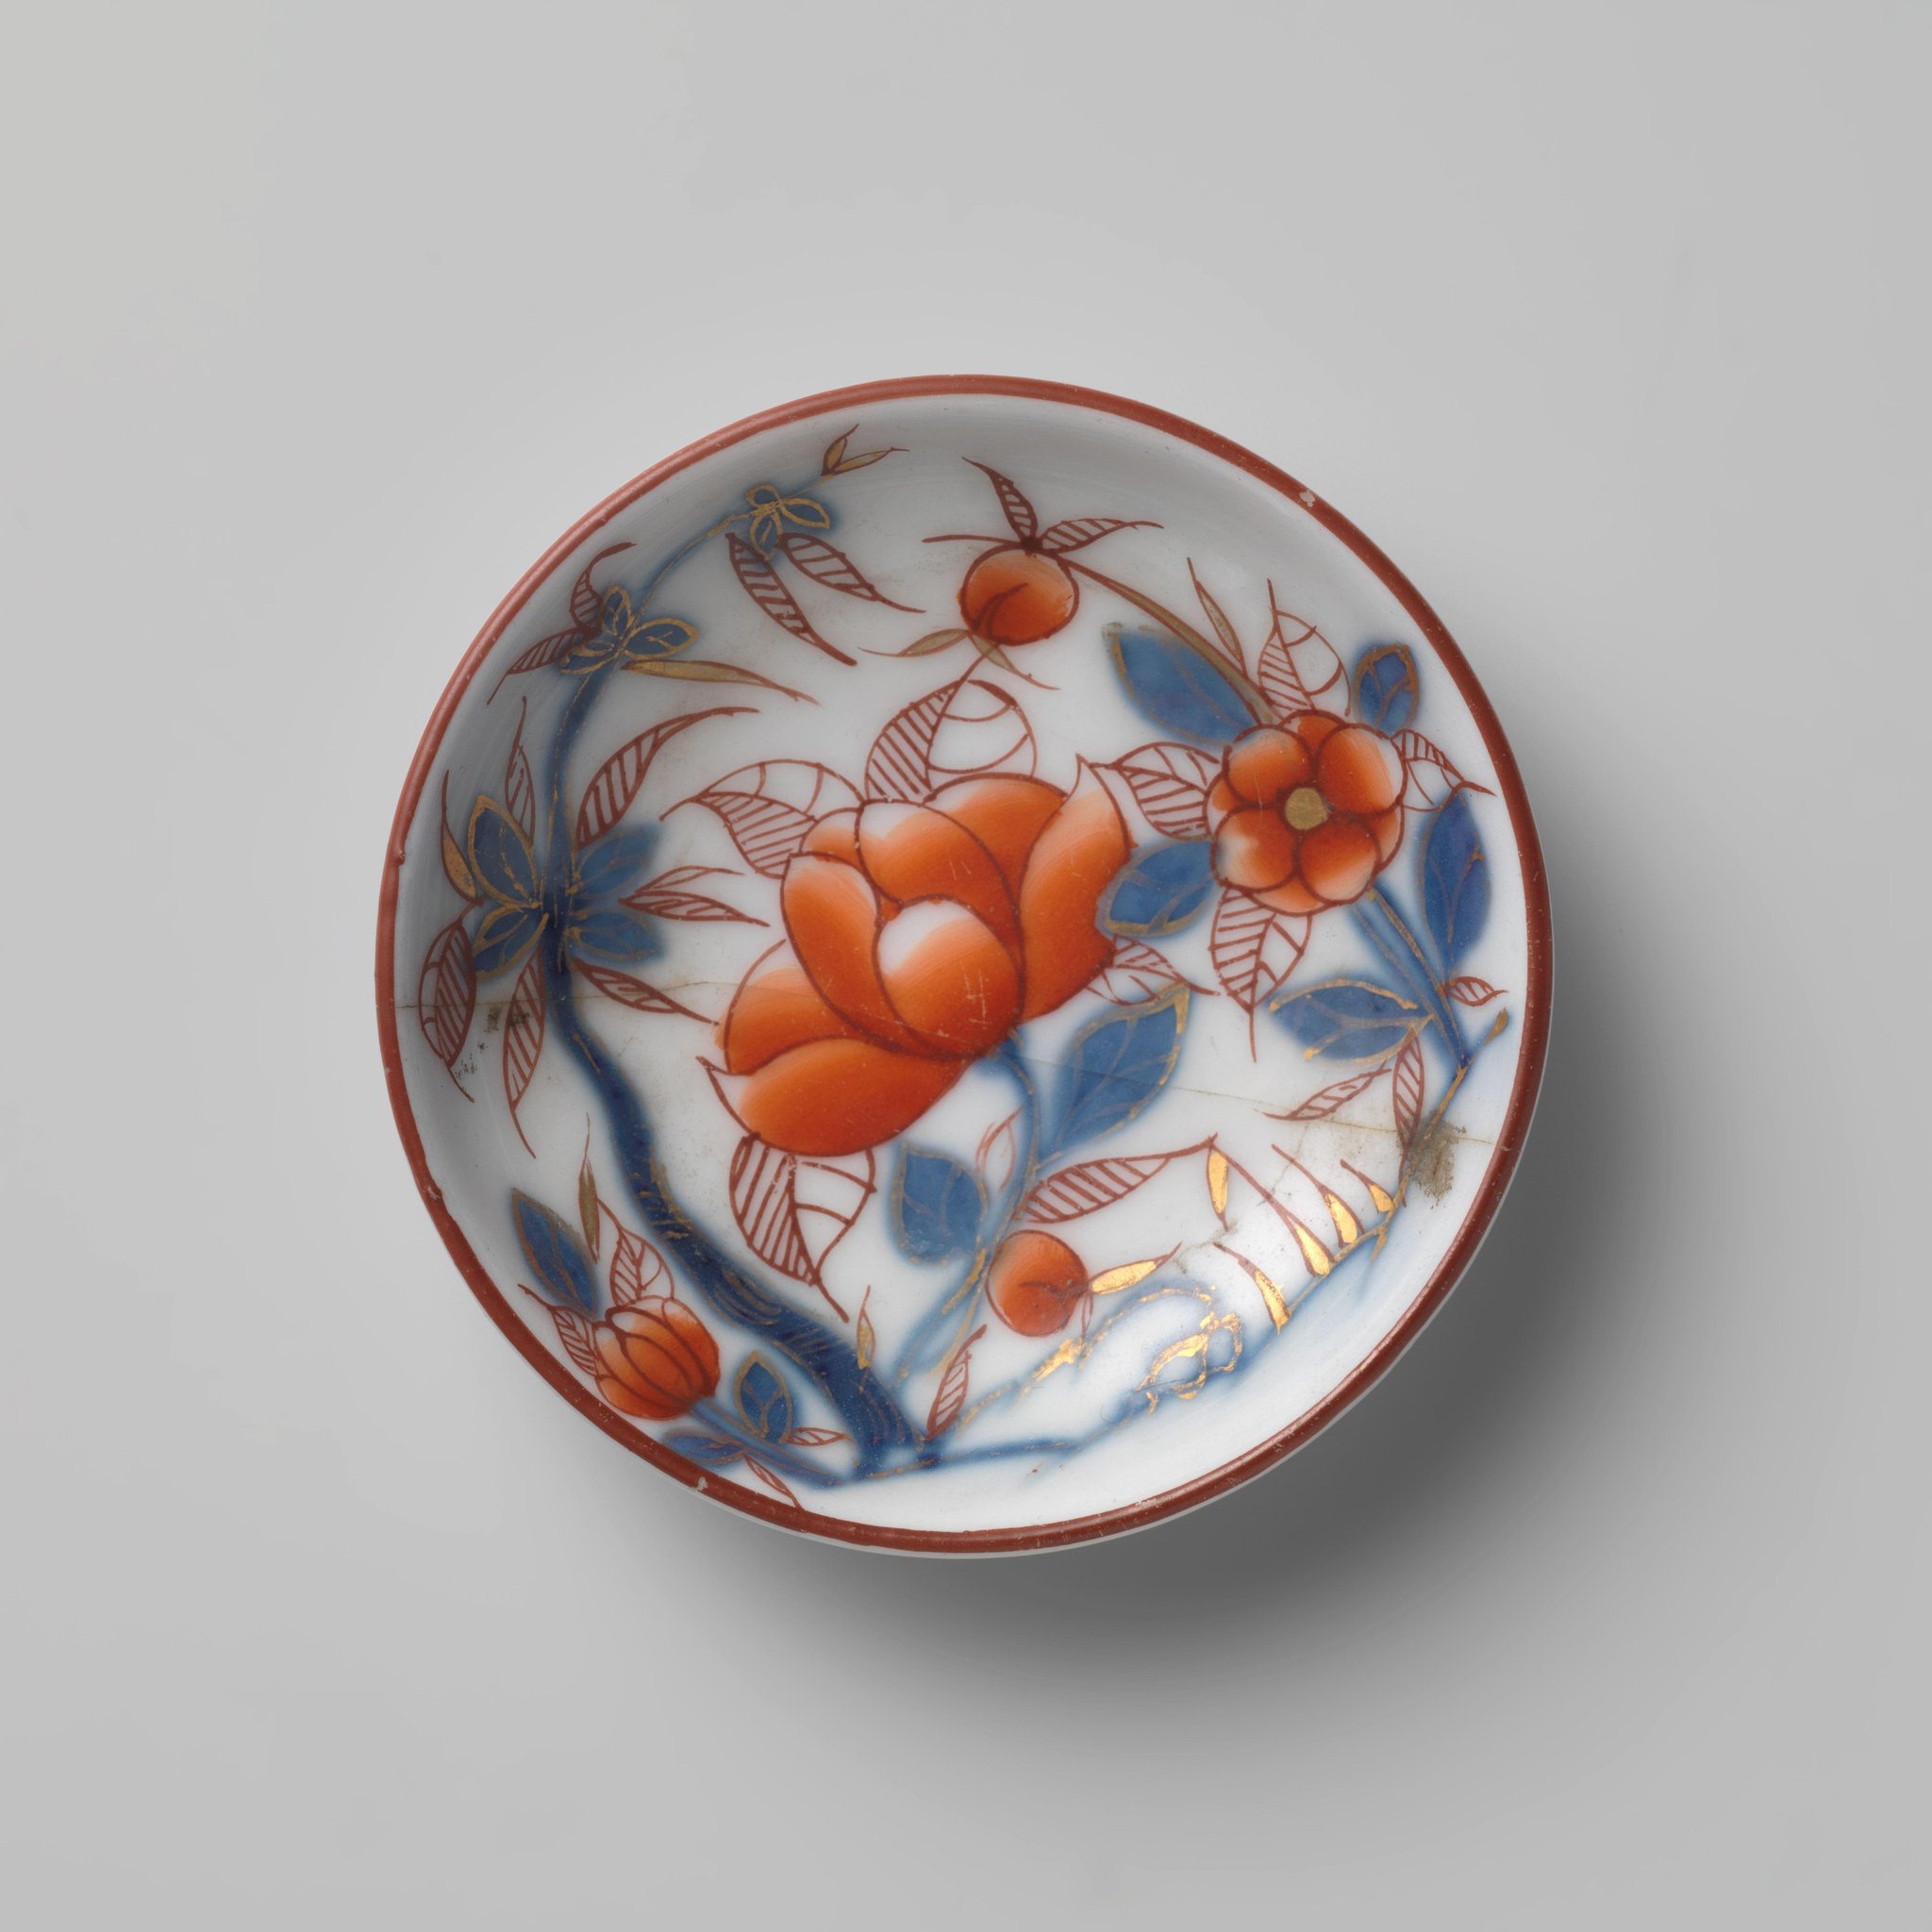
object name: kop en schotel, kop en schotel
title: Miniature suacer with flowering plants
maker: Anonymous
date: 1800-1899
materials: cobalt, glaze, gold, paint, porcelain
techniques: firing, gilding, turning, vitrification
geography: japan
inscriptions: mark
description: Miniatuur schotel van porselein, beschilderd in onderglazuur blauw en op het glazuur rood en goud. Op het plat van de schotel twee bloeiende planten. Gemerkt op de onderzijde met een zegelmerk. De schotel is gebroken geweest. Imari.